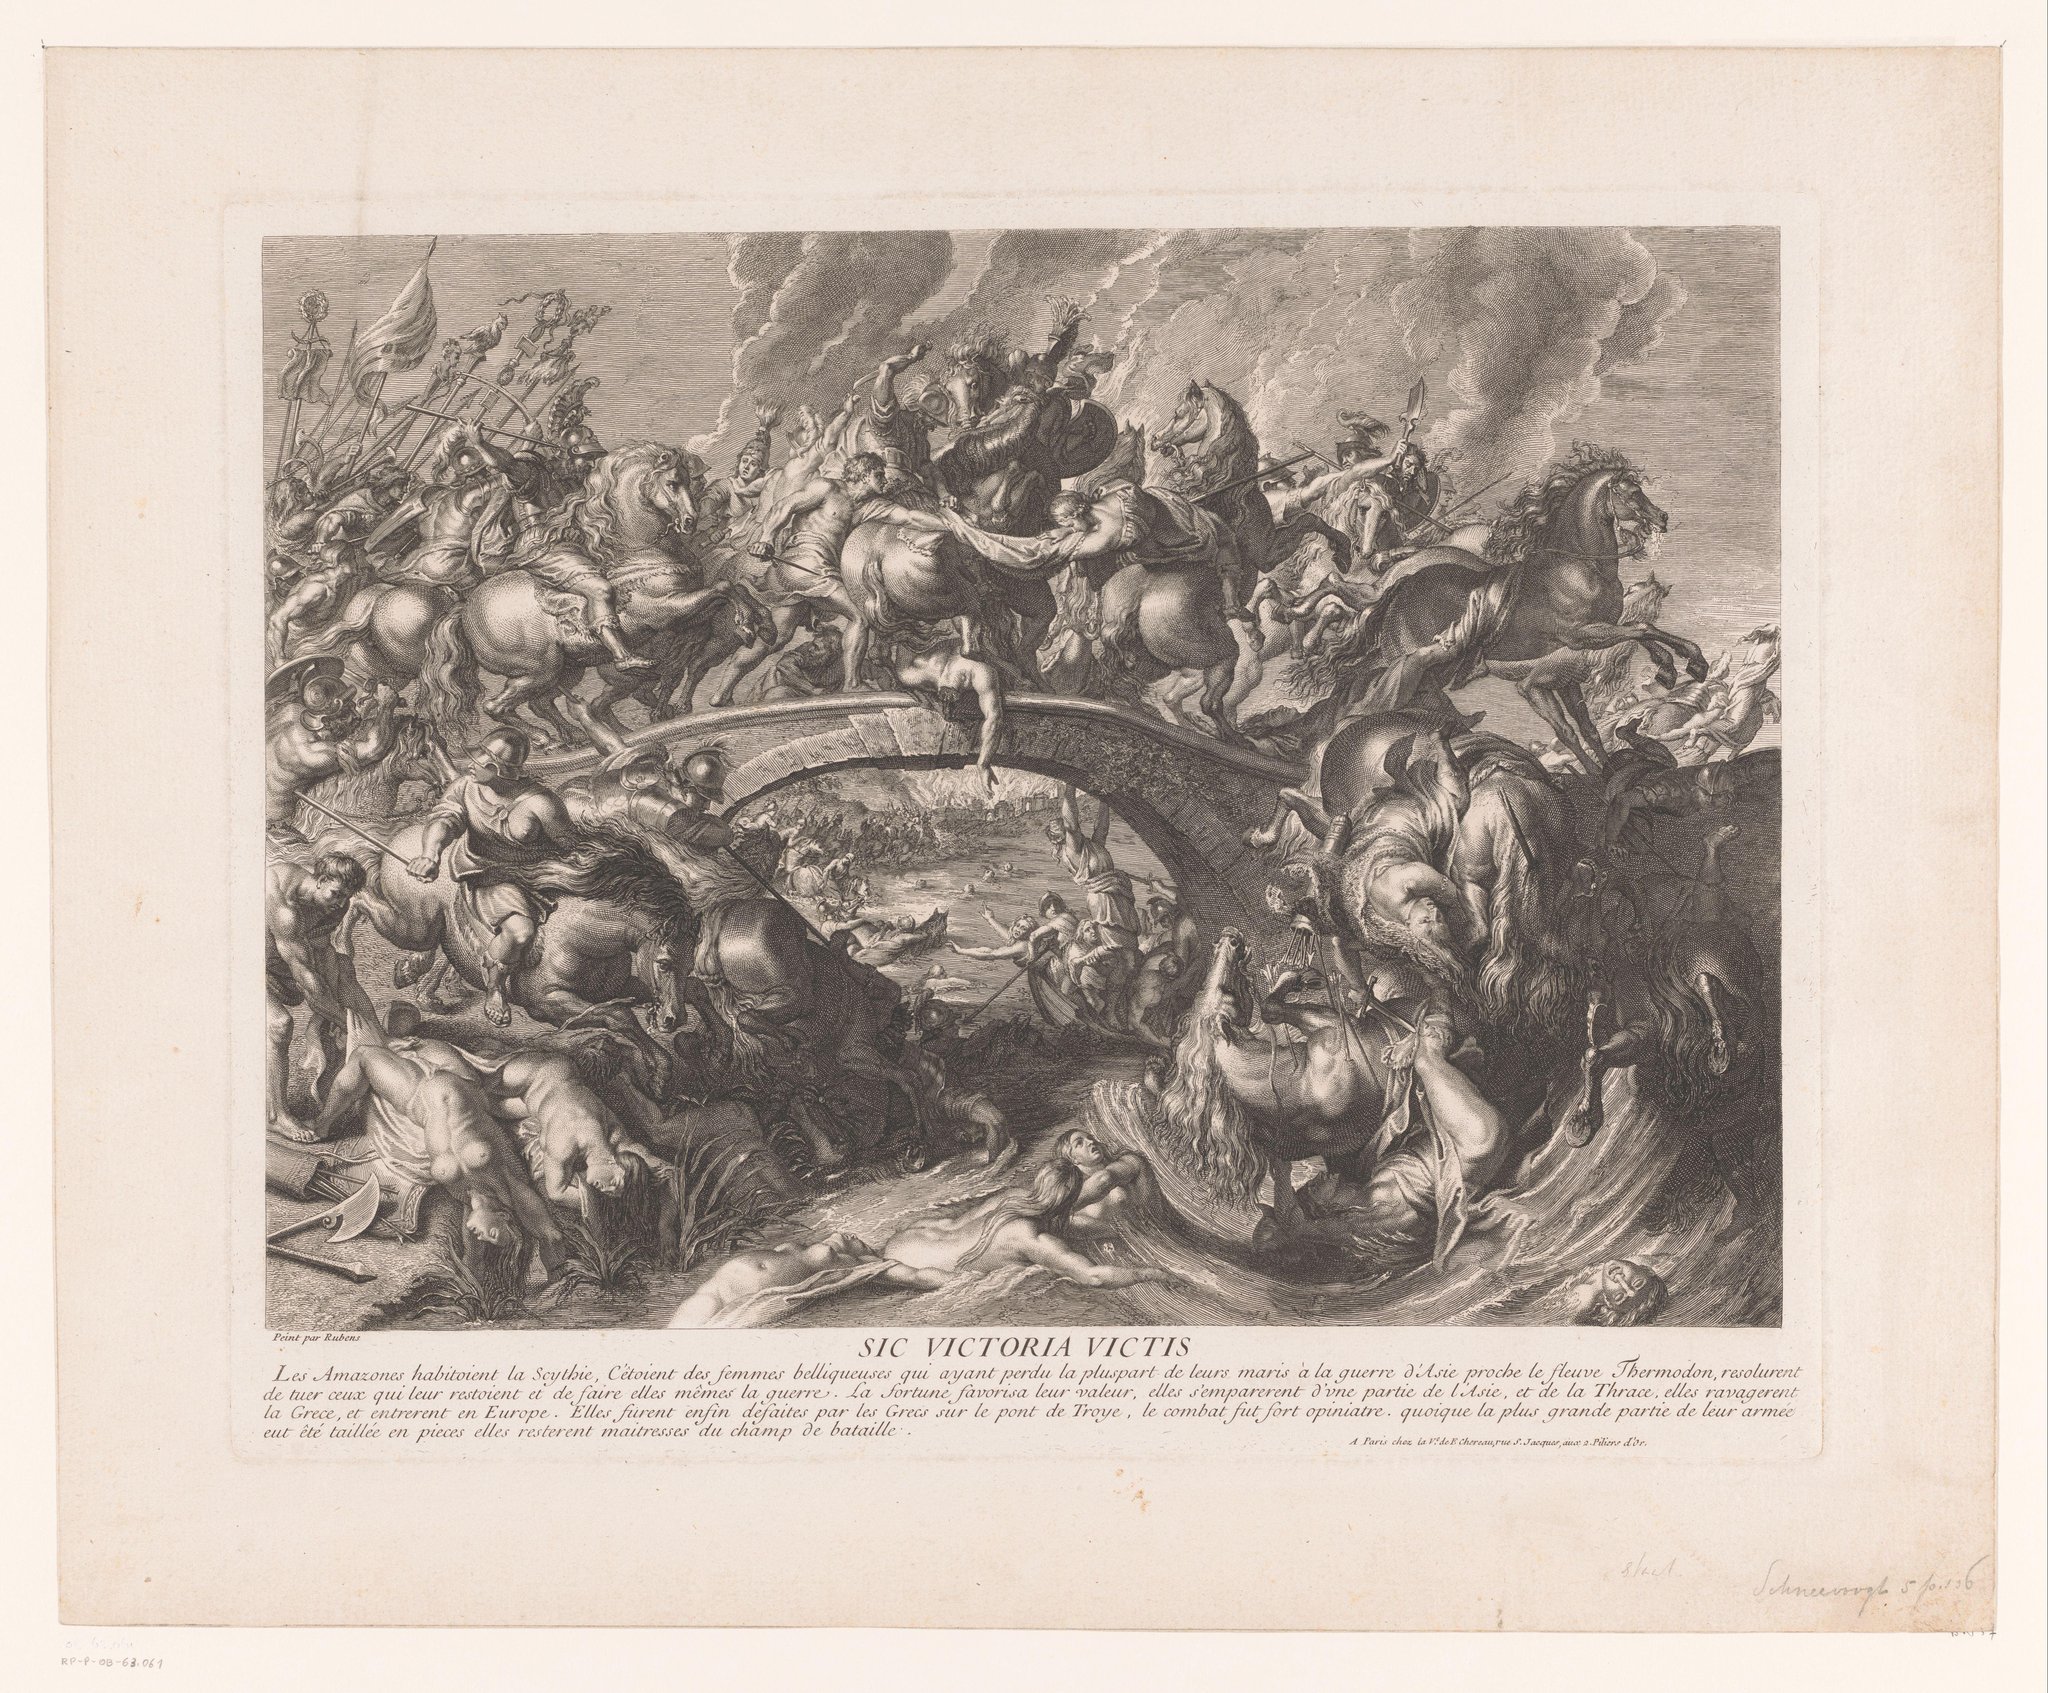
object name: print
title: Amazonenslag op een brug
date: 1700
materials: paper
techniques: engraving, etching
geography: paris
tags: battle of amazons; amazonomachy, bridge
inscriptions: collector's mark: Lugt 240